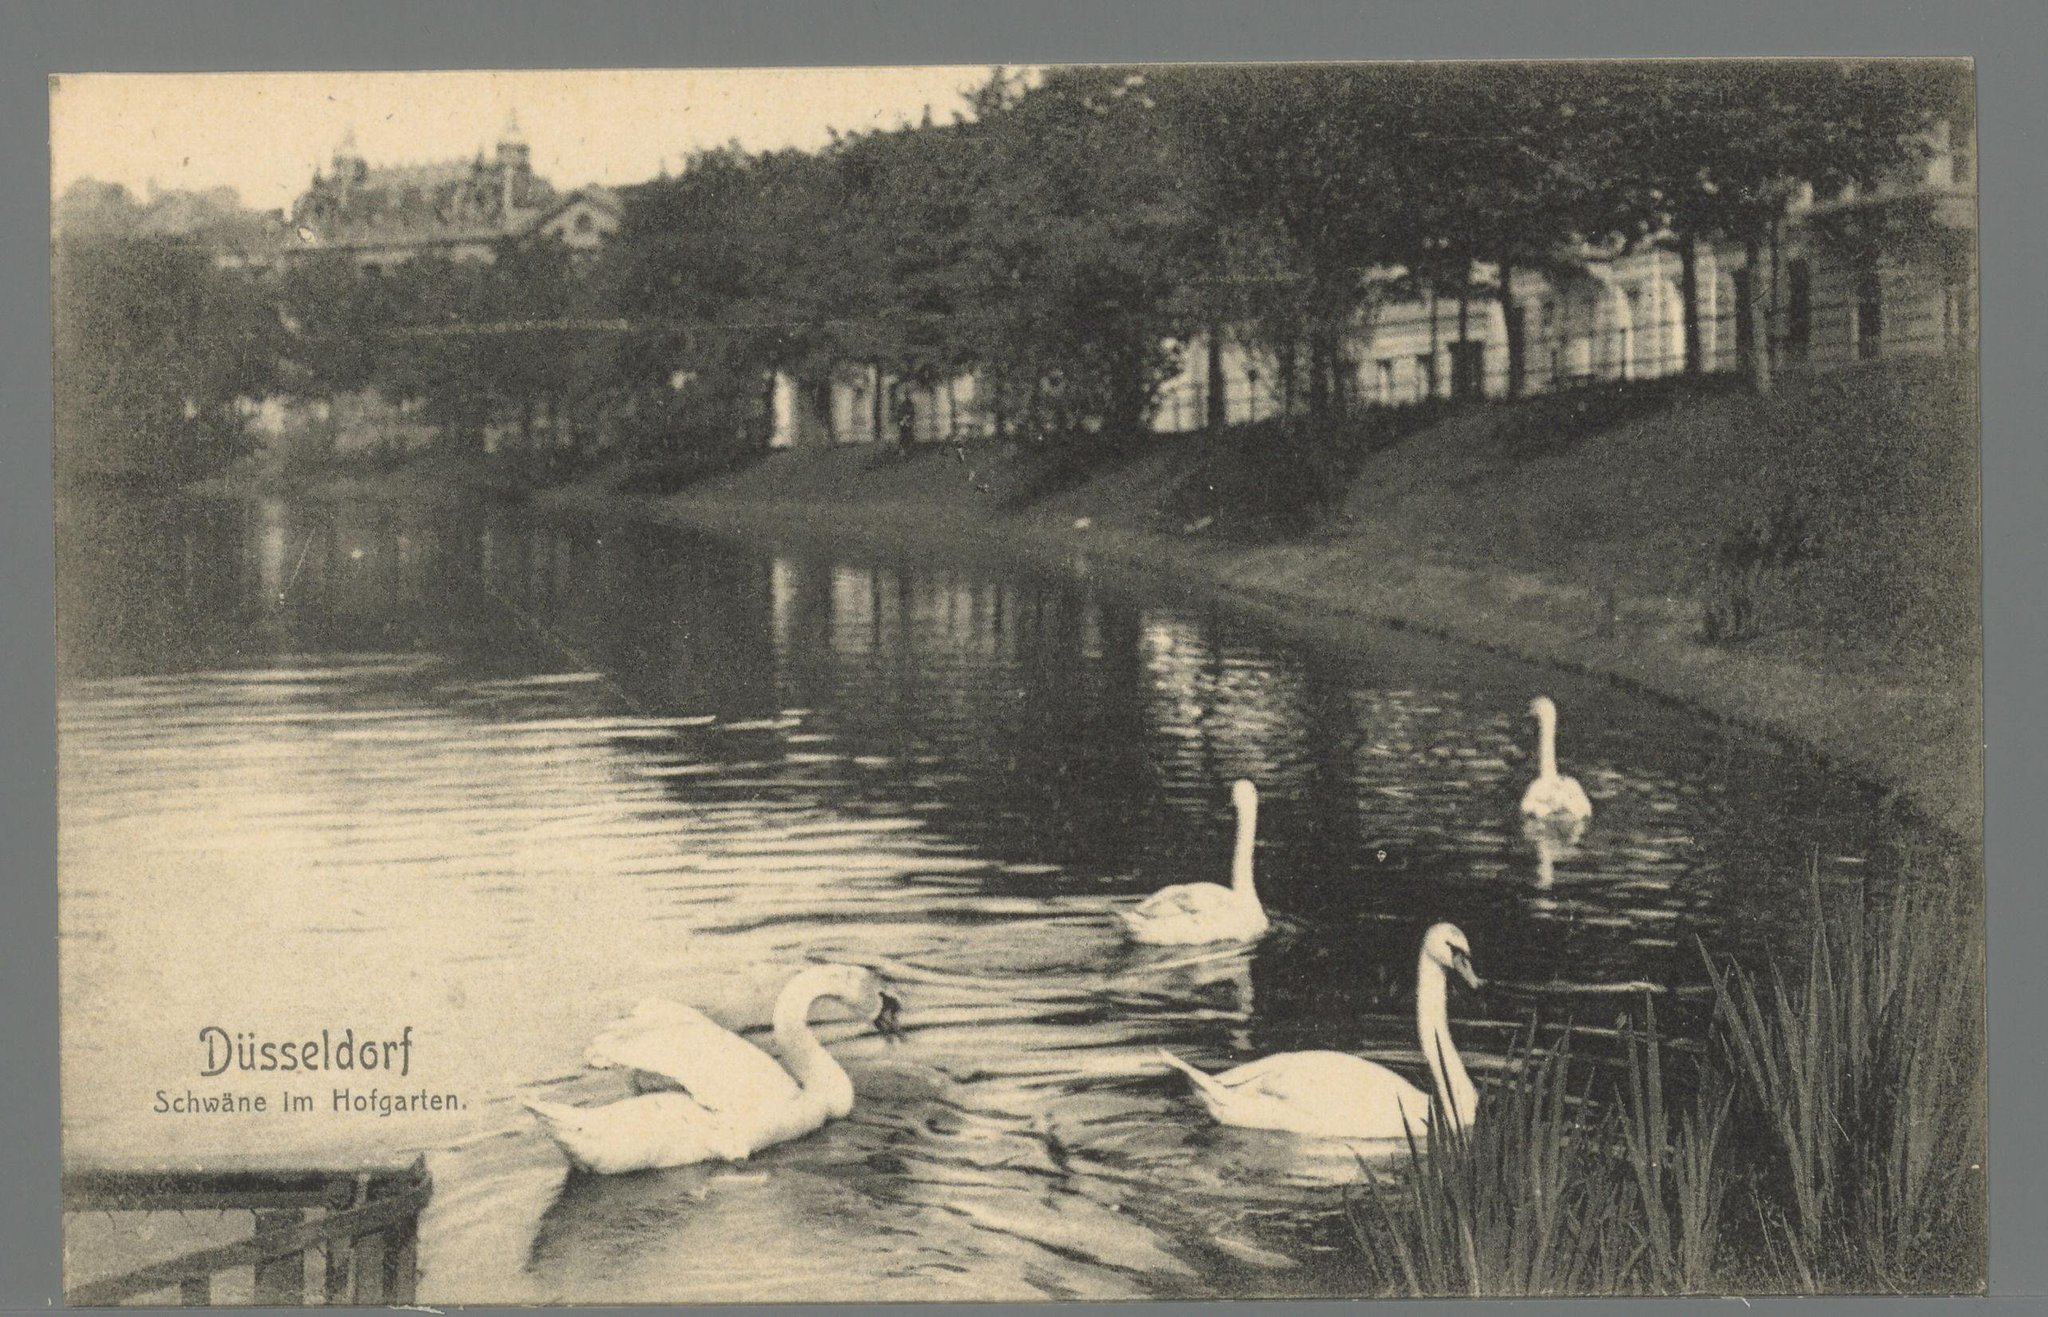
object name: ansichtkaart, prentbriefkaart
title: Düsseldorf. Schwäne im Hofgarten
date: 1905-1930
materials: cardboard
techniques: photograph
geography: dusseldorf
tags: park, water-birds: swan, pond